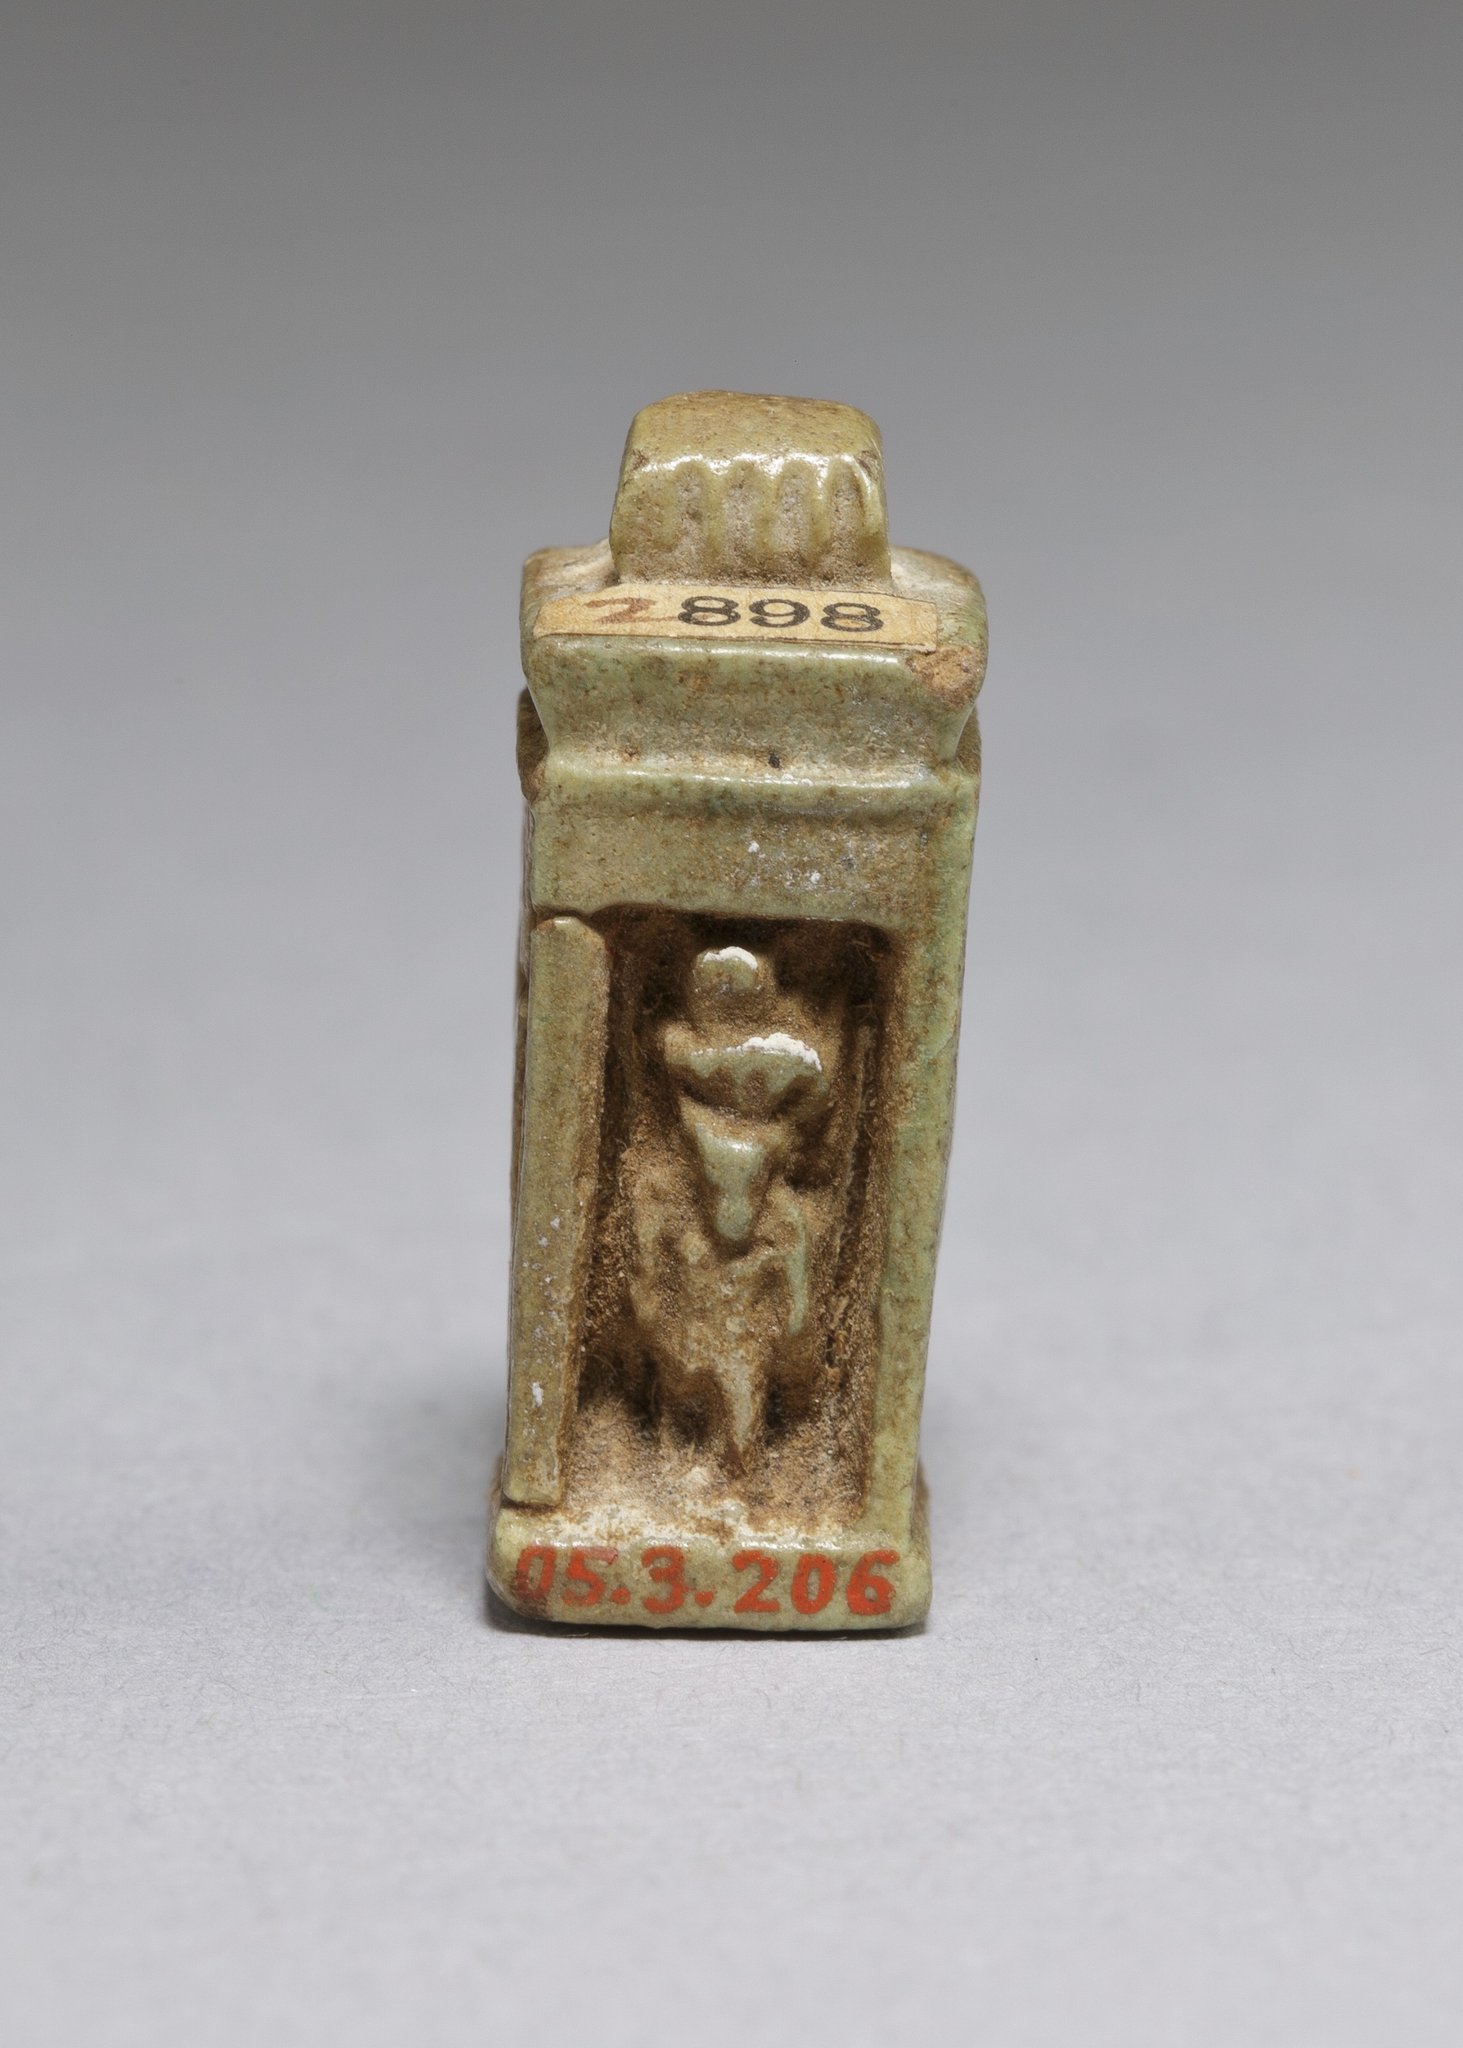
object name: amulet, shrine, nefertum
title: Shrine amulet of Nefertum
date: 664-332 BCE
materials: faience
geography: egypt